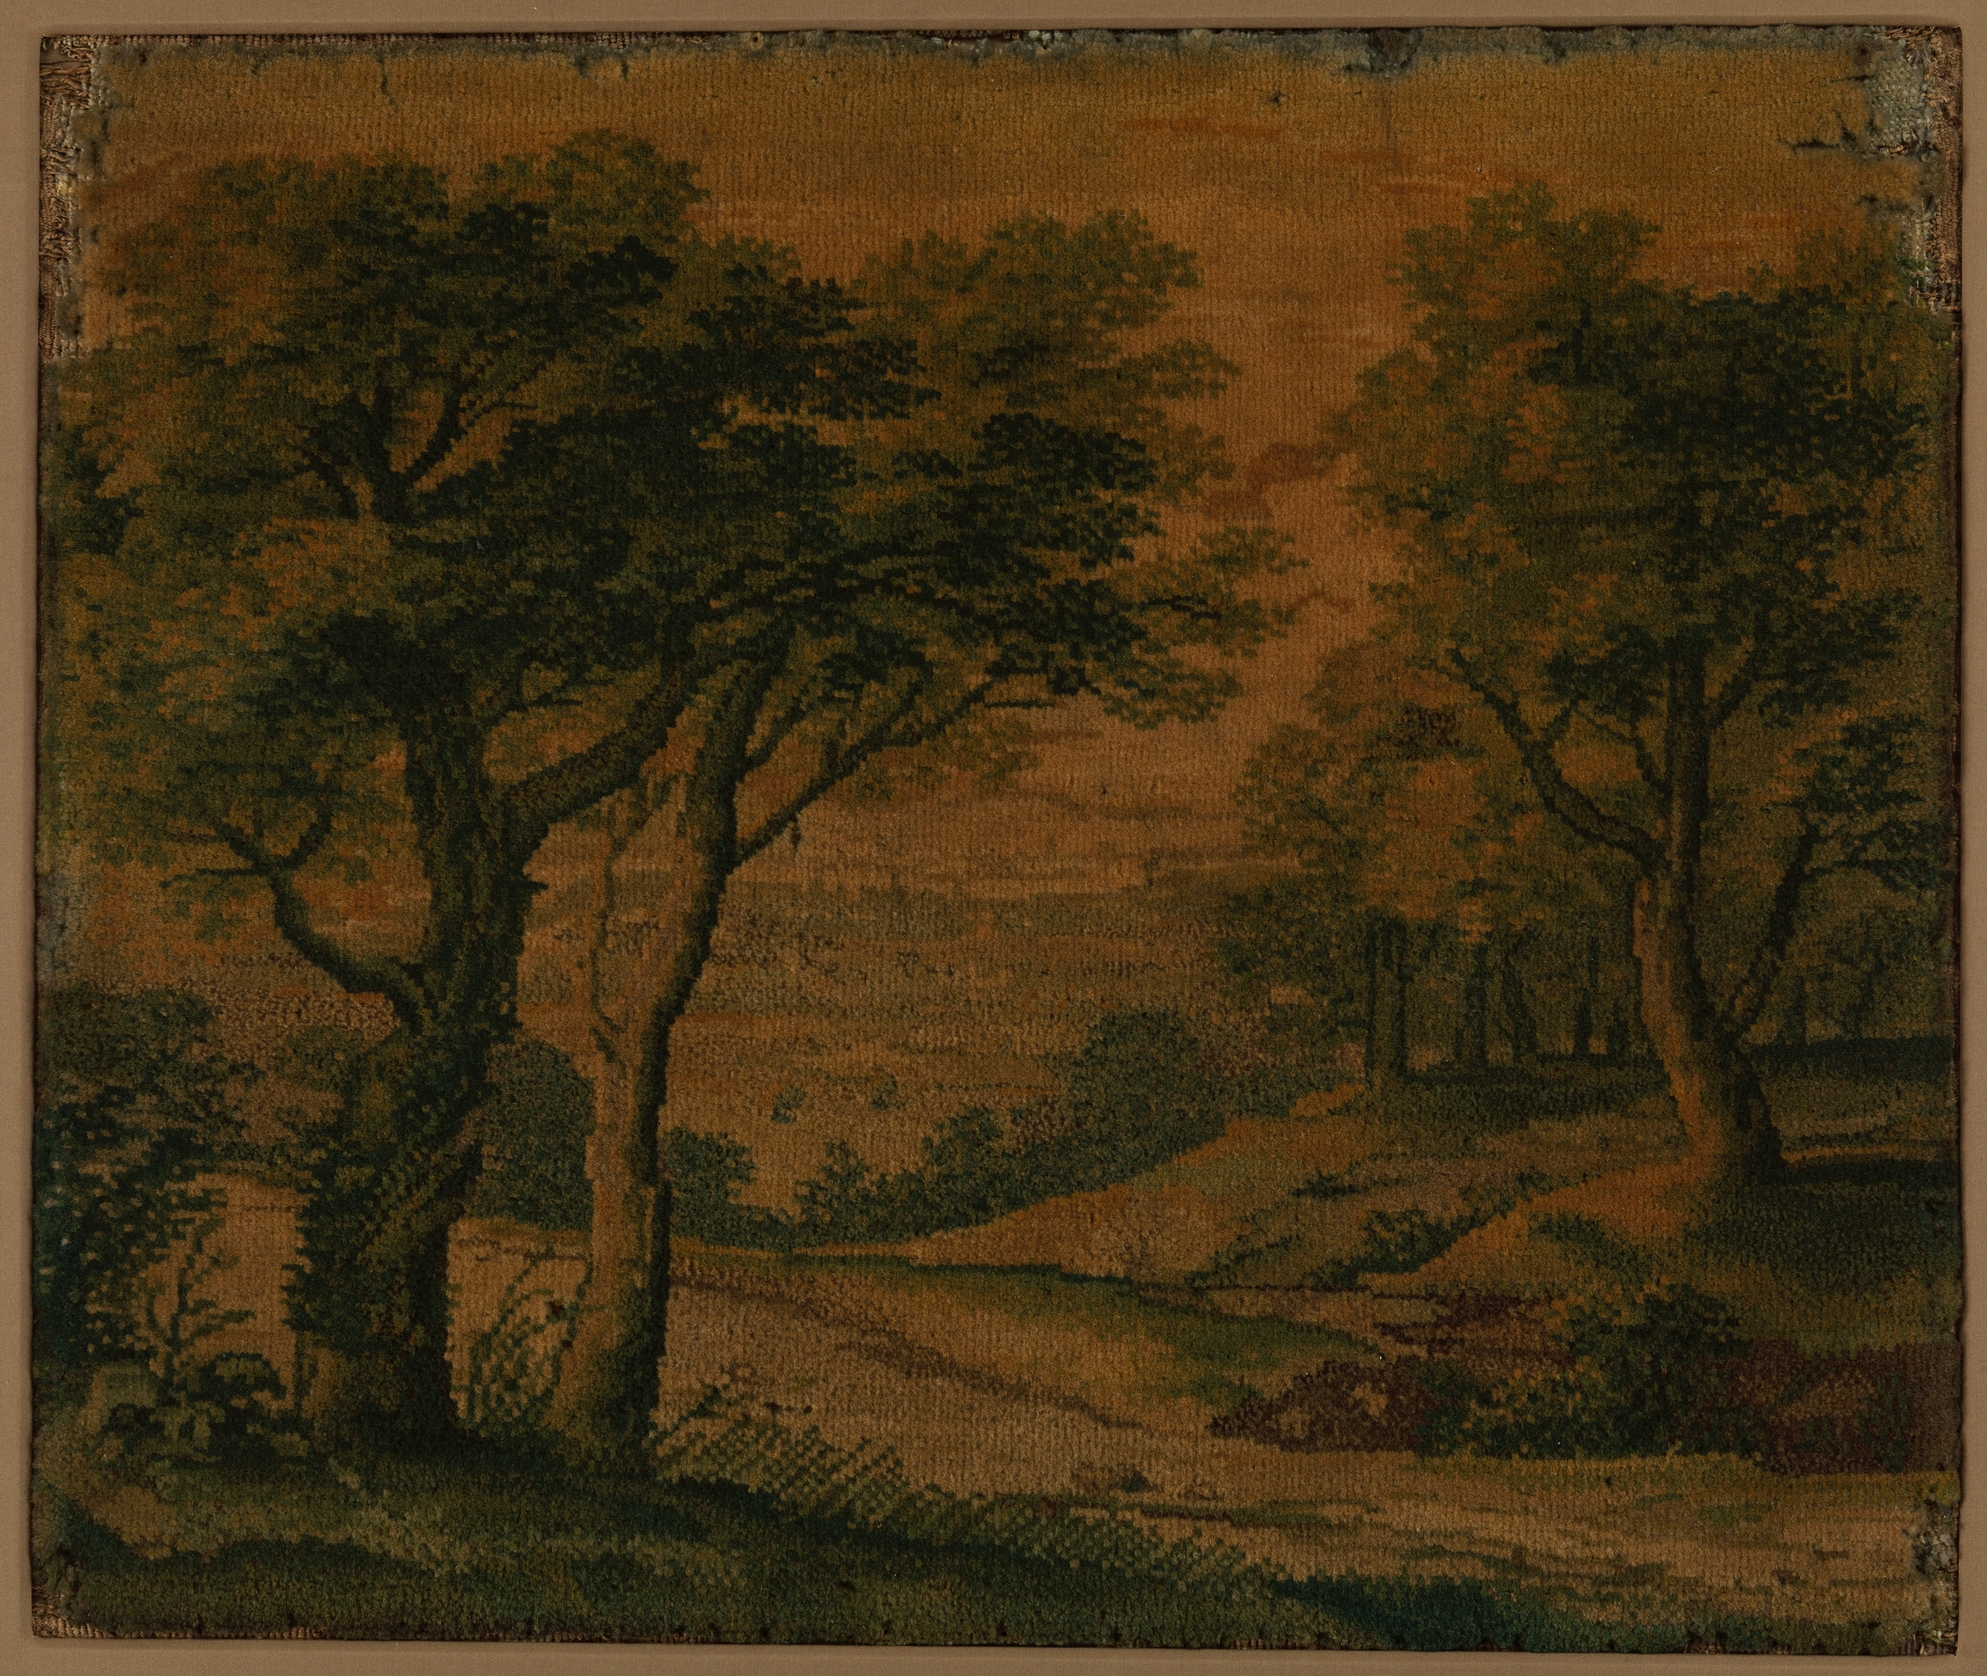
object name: panel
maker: savonnerie manufactory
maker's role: manufactory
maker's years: 1626-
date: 1634-1666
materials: wool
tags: landscapes,trees